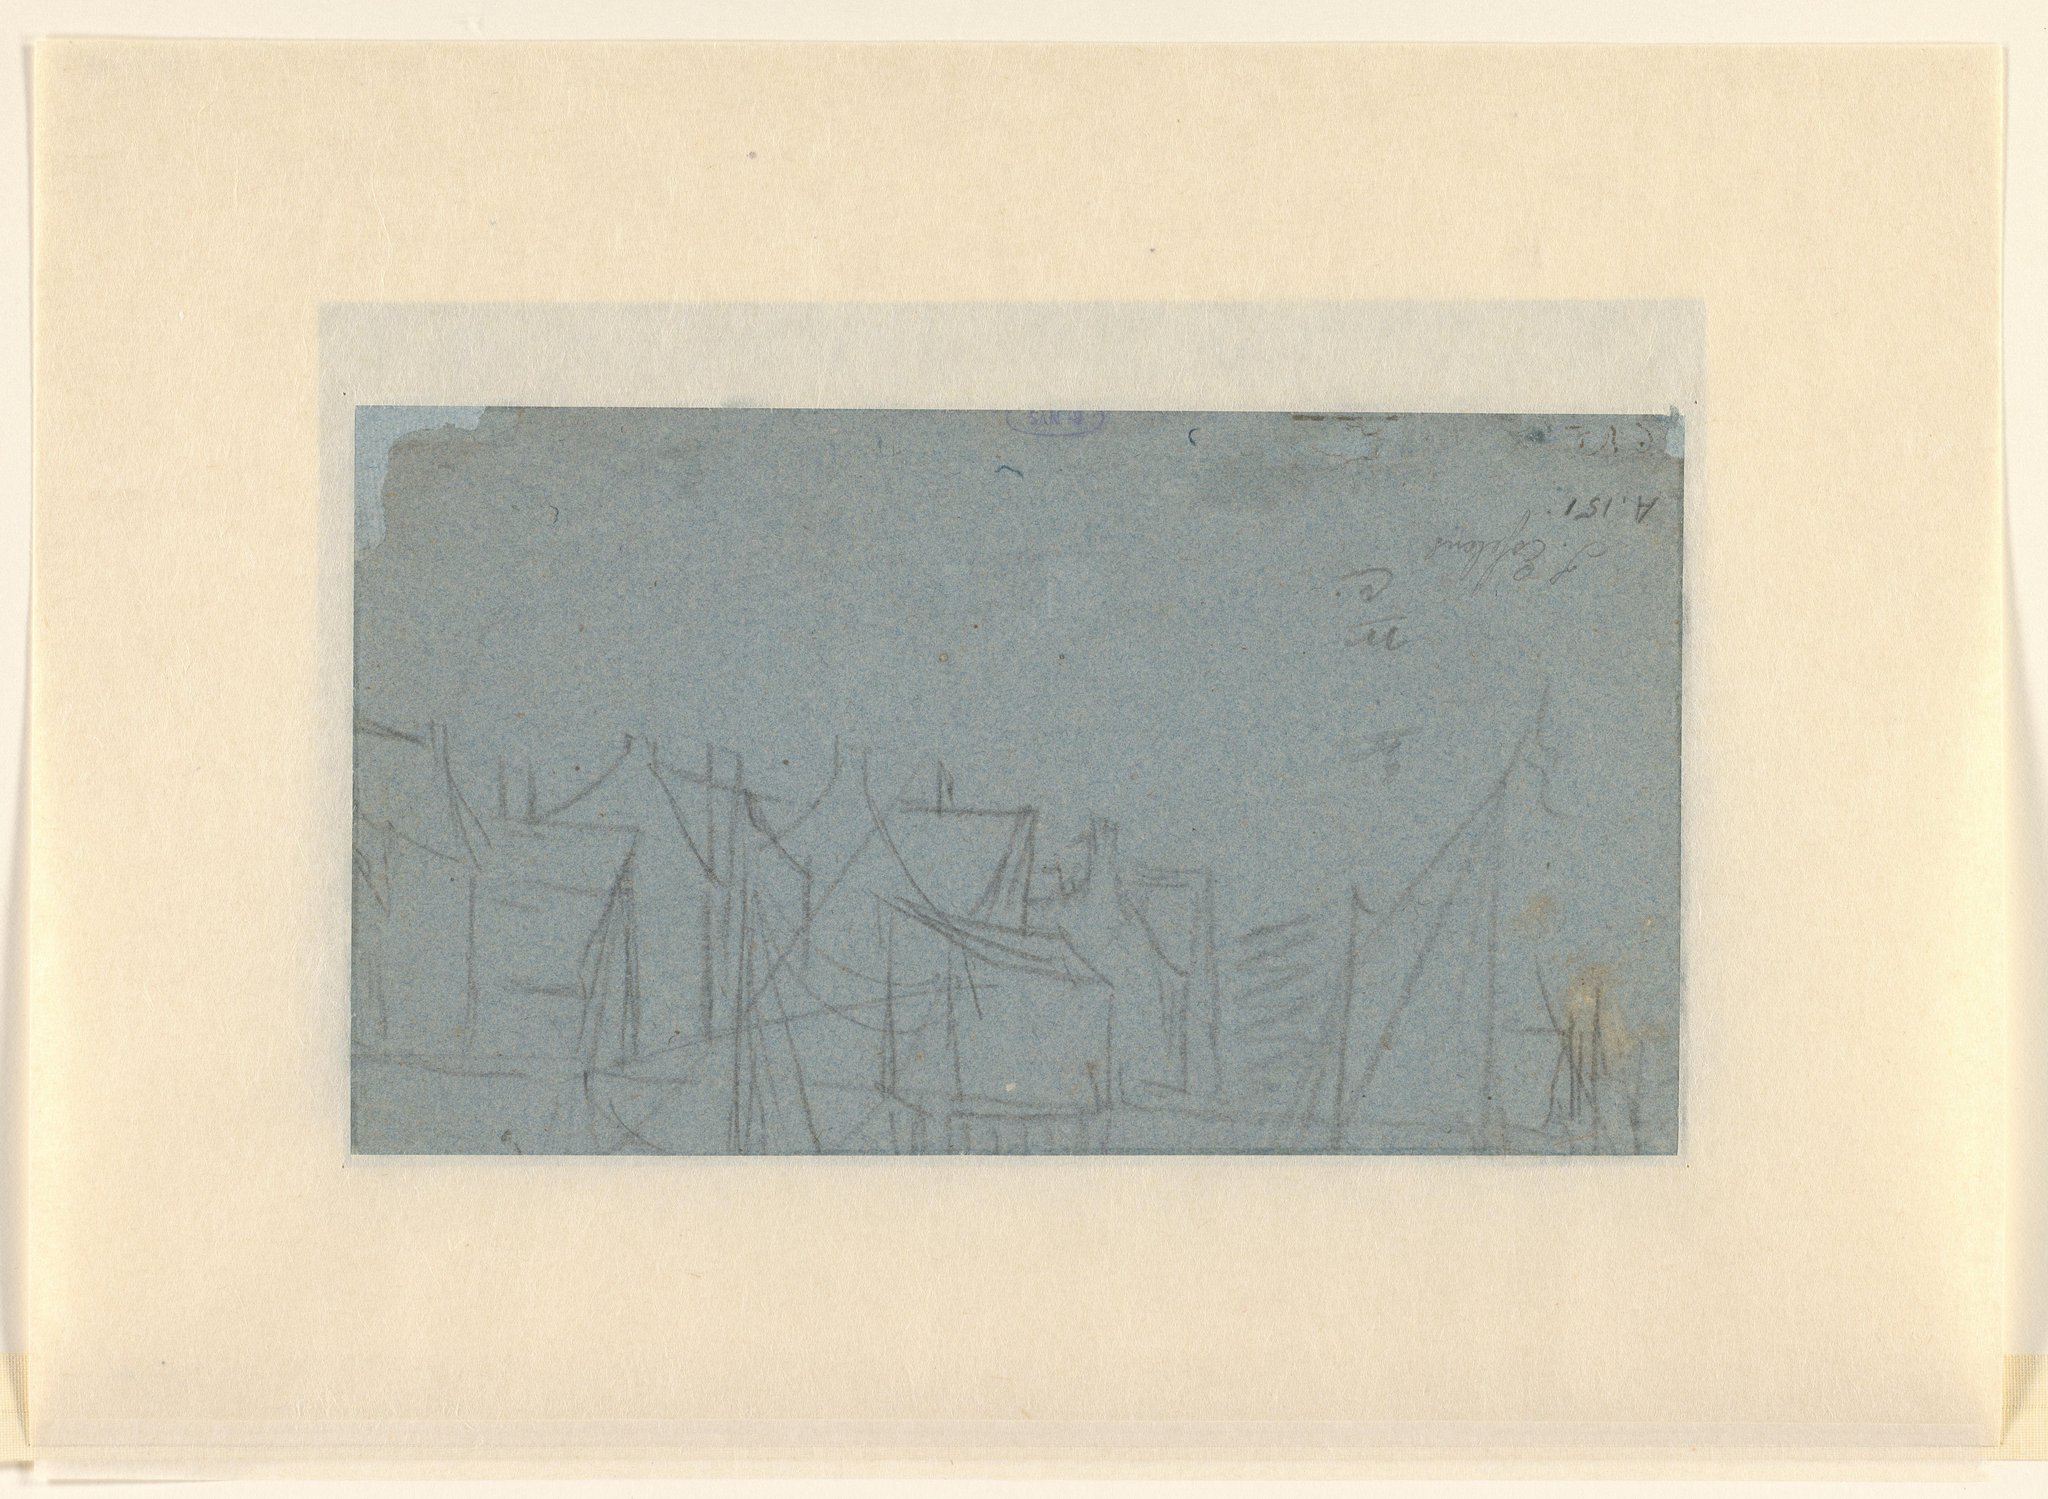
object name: drawing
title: Gevels met zeilen van boten ervoor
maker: jacob esselens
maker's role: draughtsman, print maker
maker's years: 1626-1687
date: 1636-1687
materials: chalk, paper